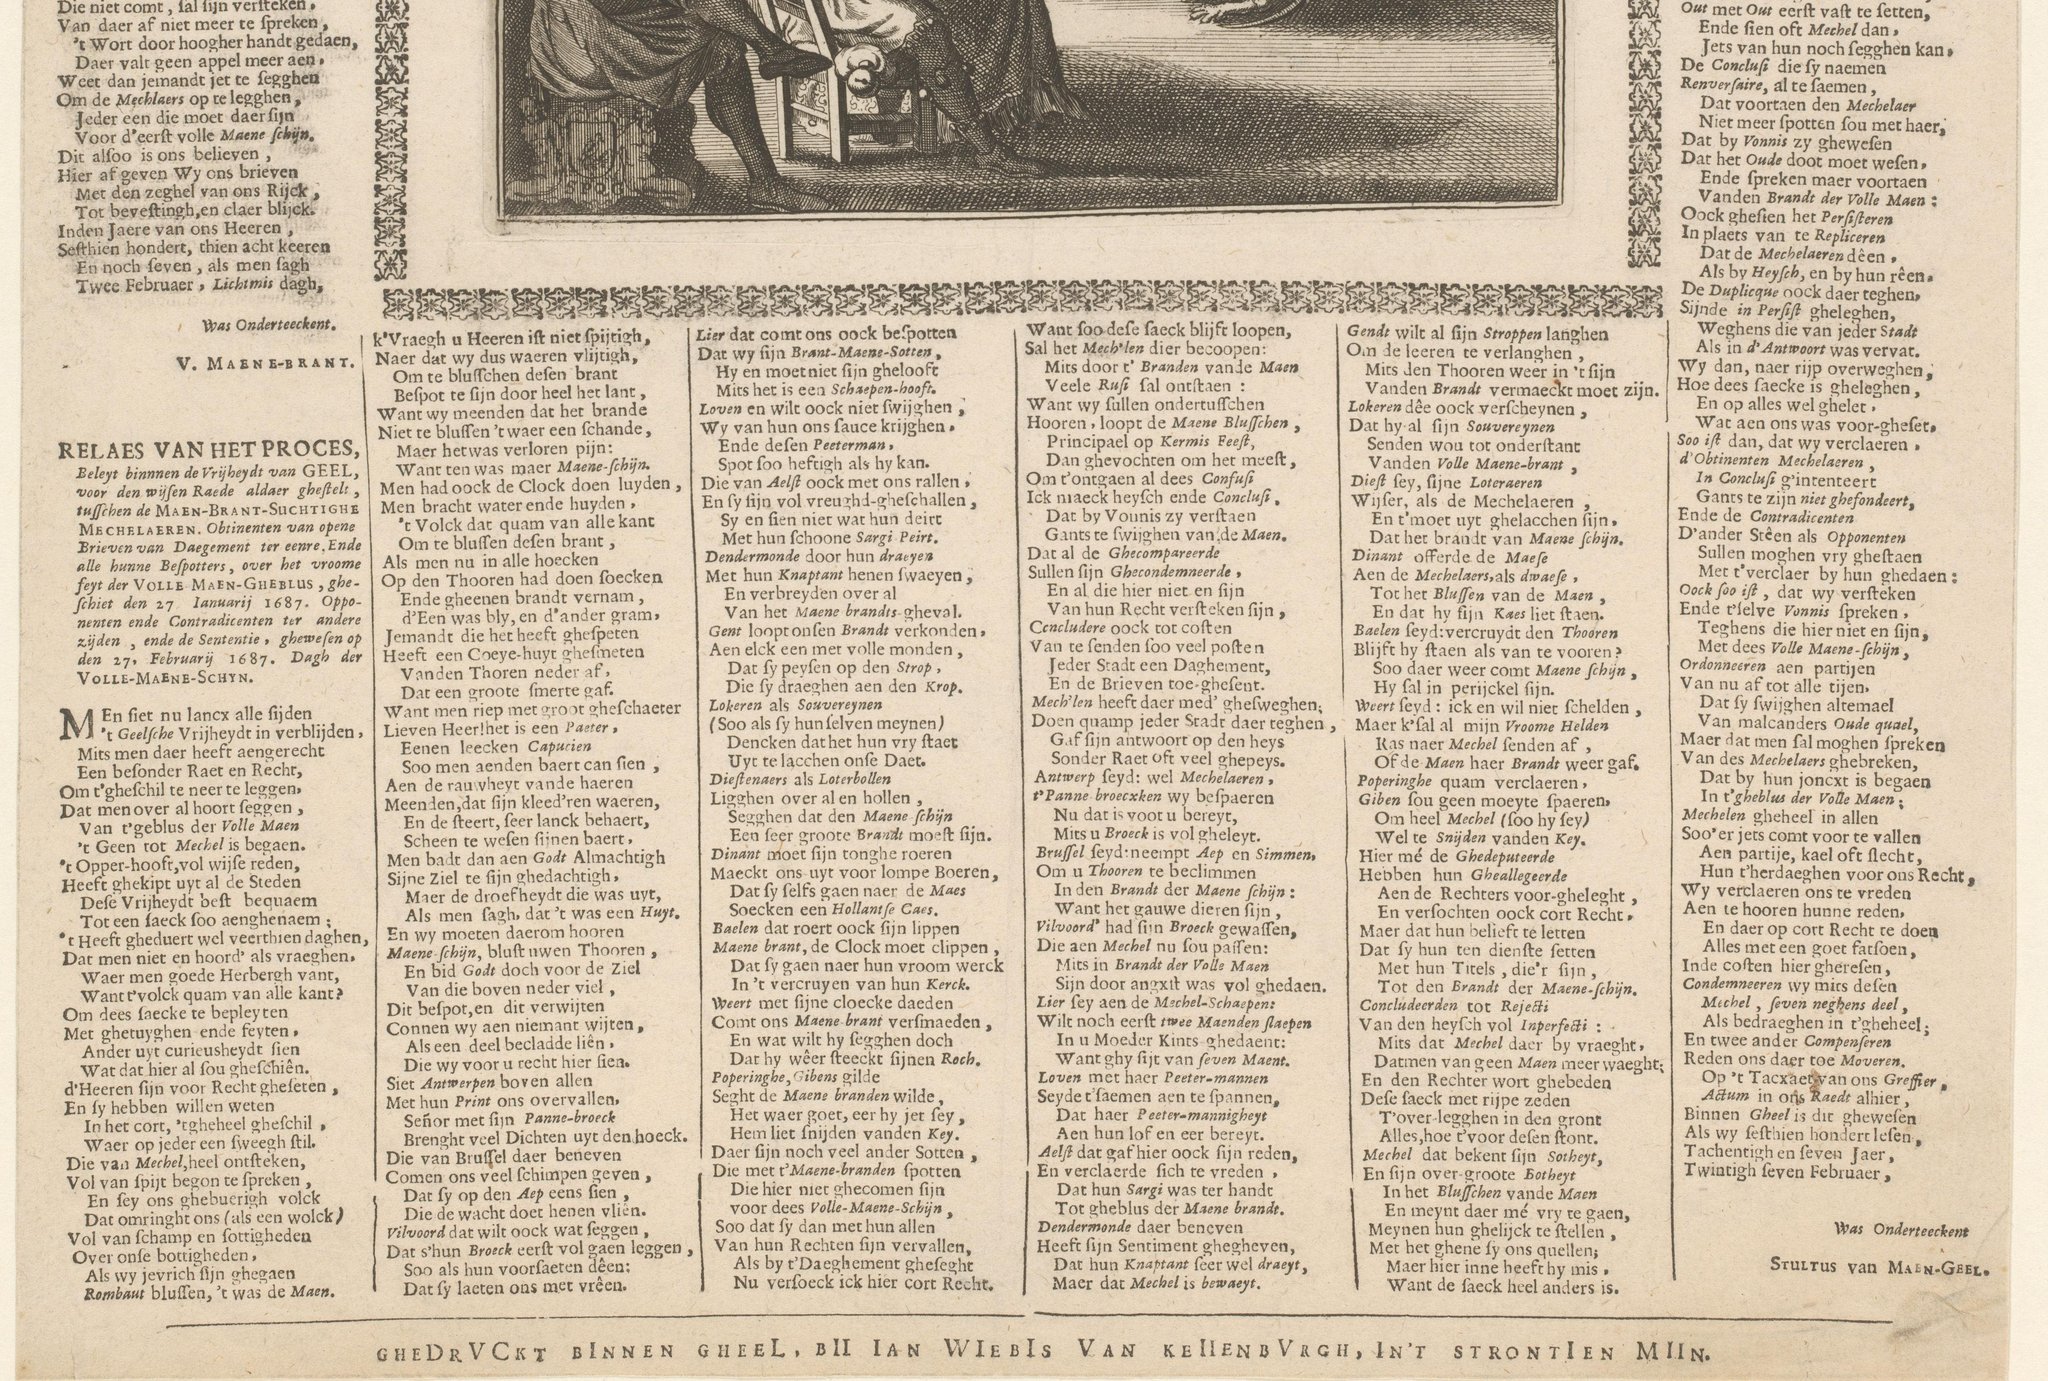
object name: print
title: Spotprent op de Mechelse maanbrand, 1687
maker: Anonymous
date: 1687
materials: paper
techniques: etching, letterpress printing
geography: southern netherlands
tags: court session (court of justice), mechelen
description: Spotprent op de Mechelse maanbrand, op de inwoners van Mechelen die ten onrechte meenden dat de toren van de Sint-Rombaut in brand stond, 27 januari 1687. Rechtszitting waarin een voorstelling van dit voorval wordt gepresenteerd door een man en een aap aan de president van een hof van narren. De president zit op zijn troon onder een grote narrenkap, aan de muur 14 voorstellingen van andere dwaasheden in Zuid-Nederlandse steden. Om en onder de plaat een relaas van het proces met sentencie.